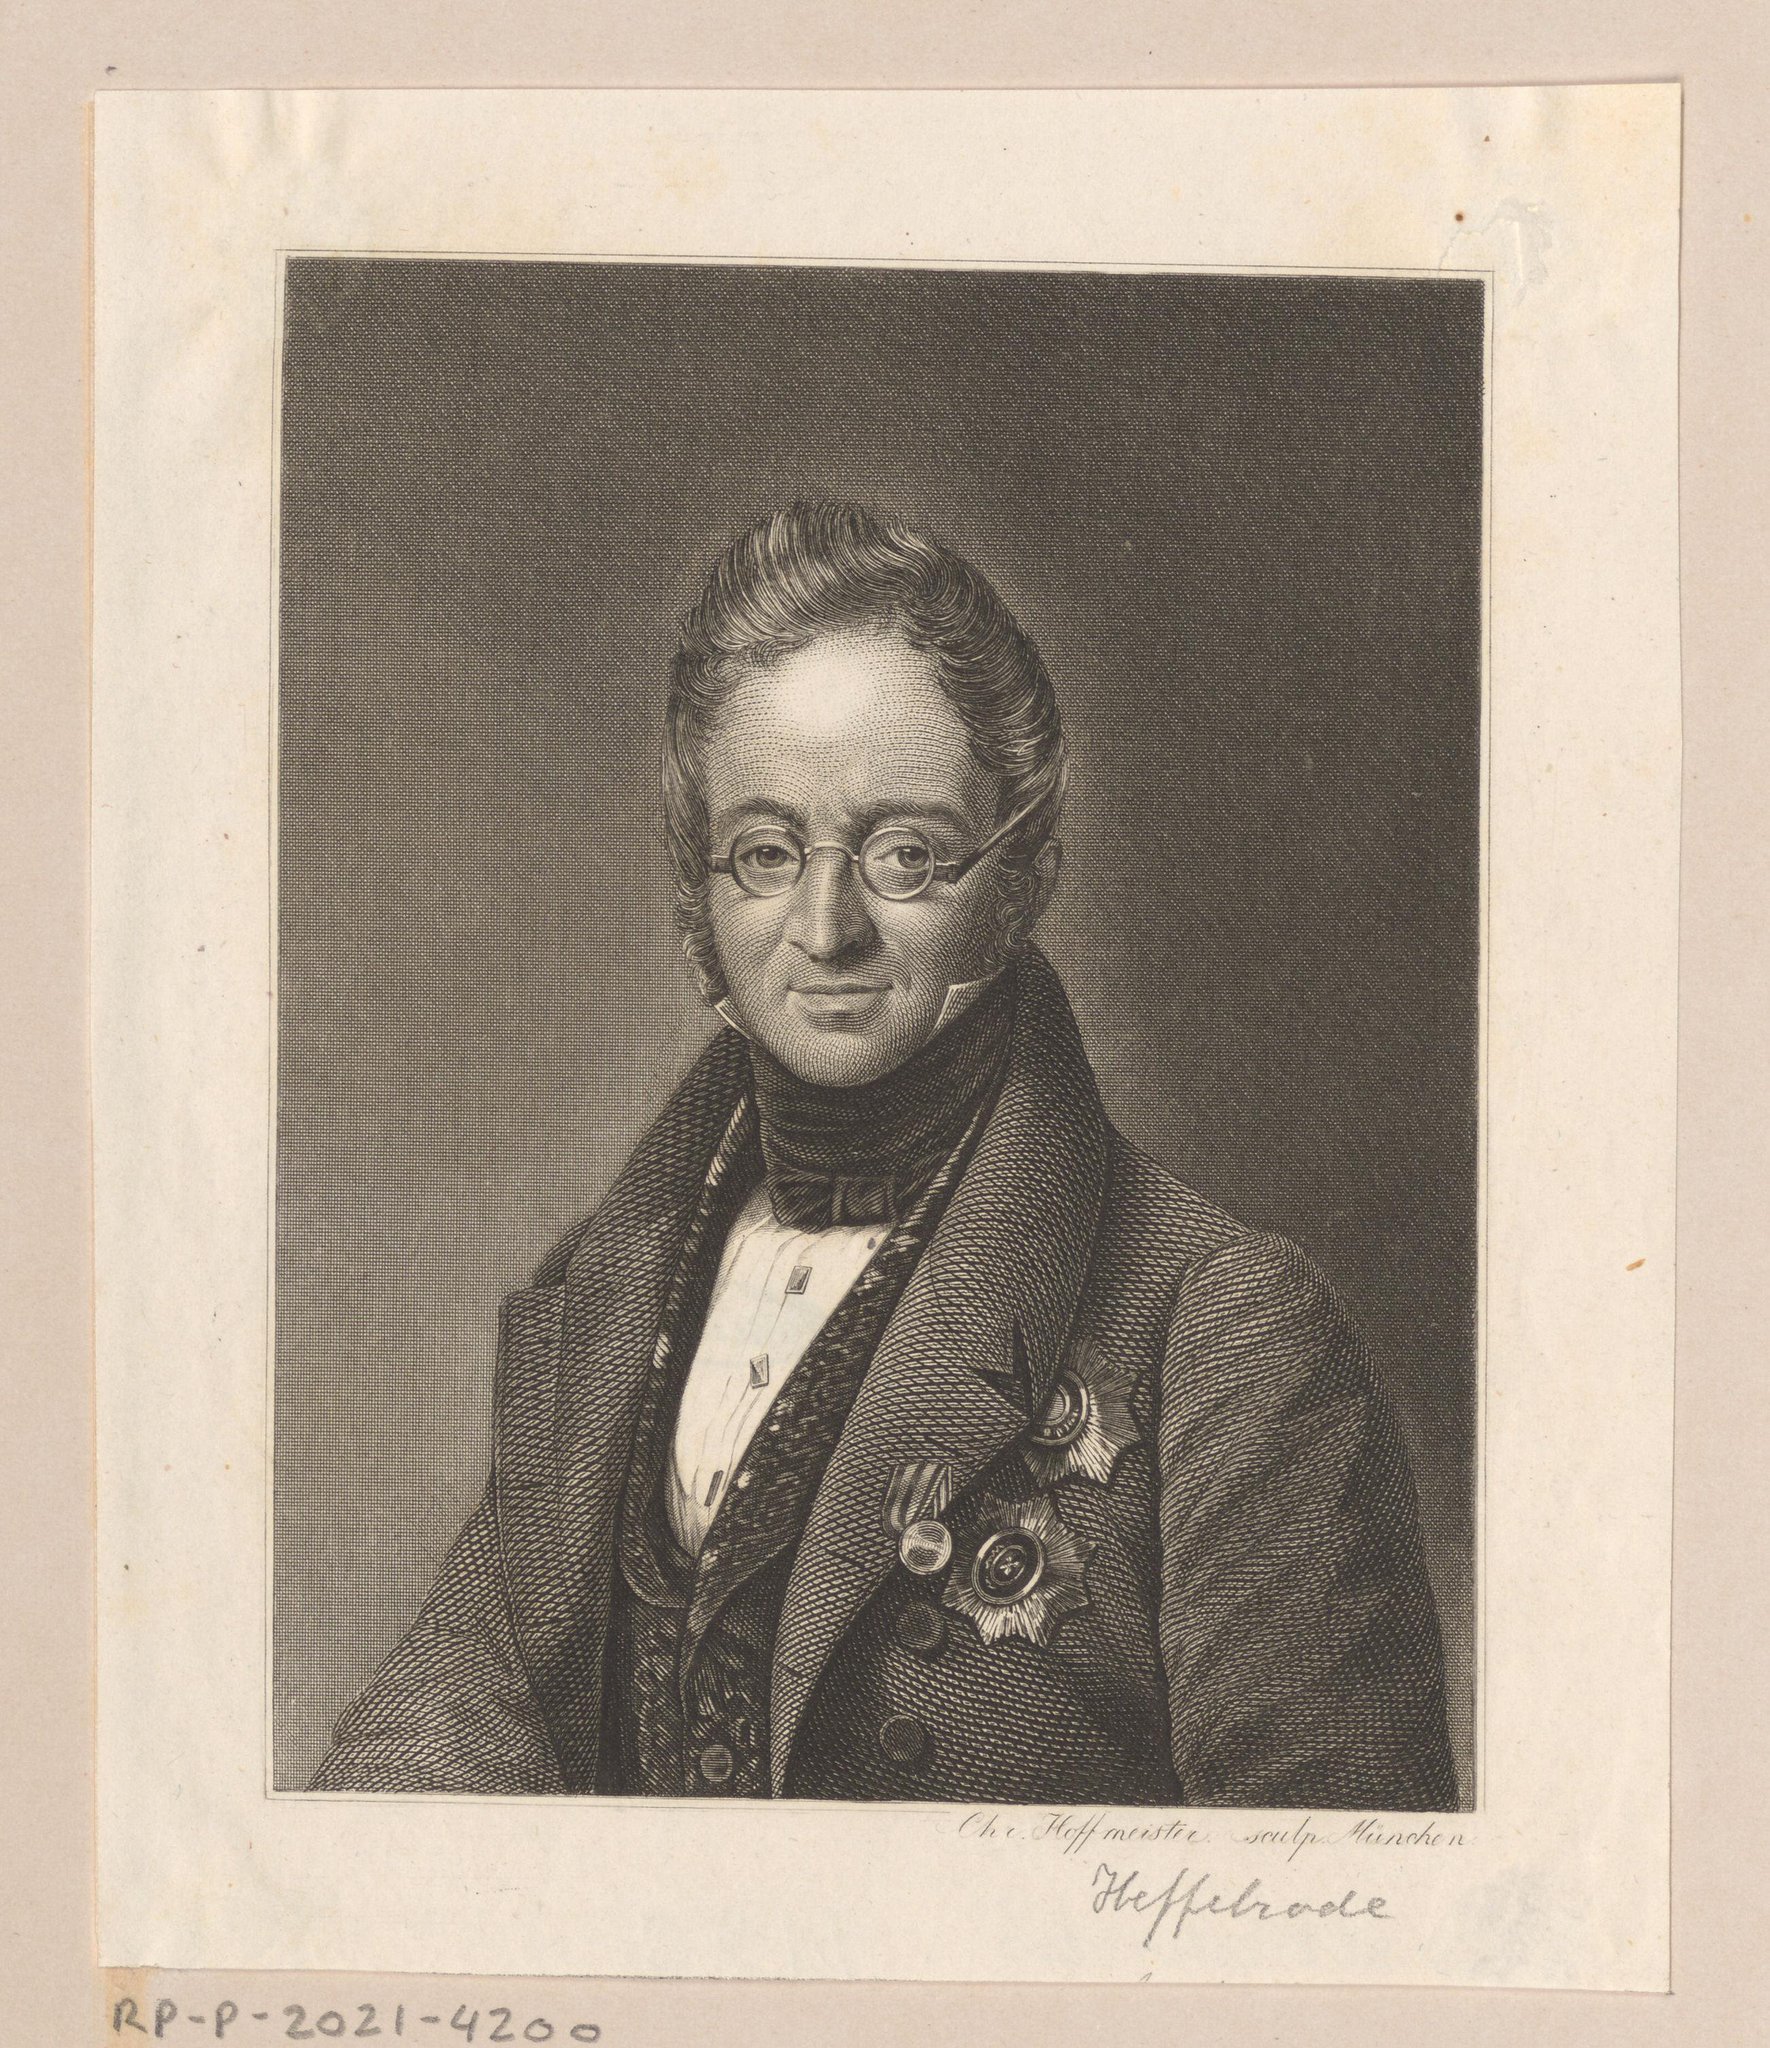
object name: print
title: Portret van Karl Robert von Nesselrode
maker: christian hoffmeister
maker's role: print maker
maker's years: 1818-1871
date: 1828-1871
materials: paper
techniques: engraving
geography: munich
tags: historical persons, diplomacy, diplomat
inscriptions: collector's mark: Lugt 2228